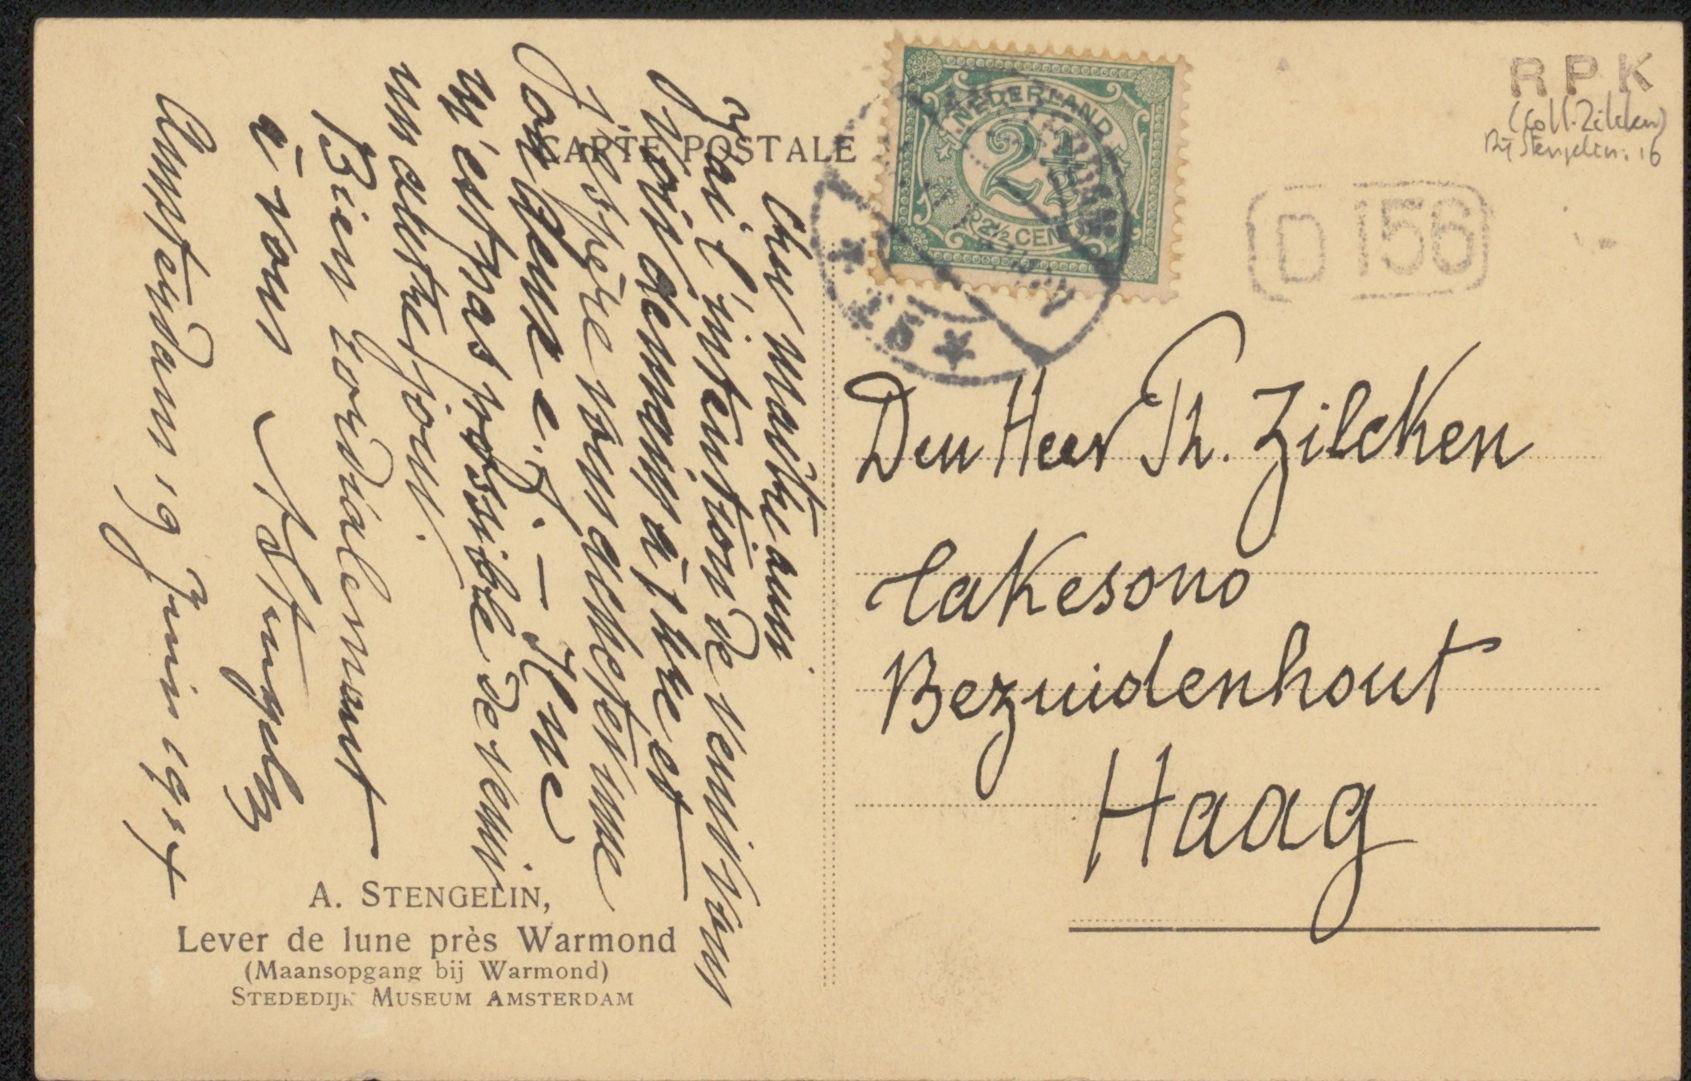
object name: ansichtkaart, prentbriefkaart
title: Prentbriefkaart aan Philip Zilcken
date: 1914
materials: cardboard, ink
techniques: photograph, pen, writing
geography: amsterdam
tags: museum, painter, draughtsman, philip zilcken, the graphic arts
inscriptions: collector's mark: ‘RPK’